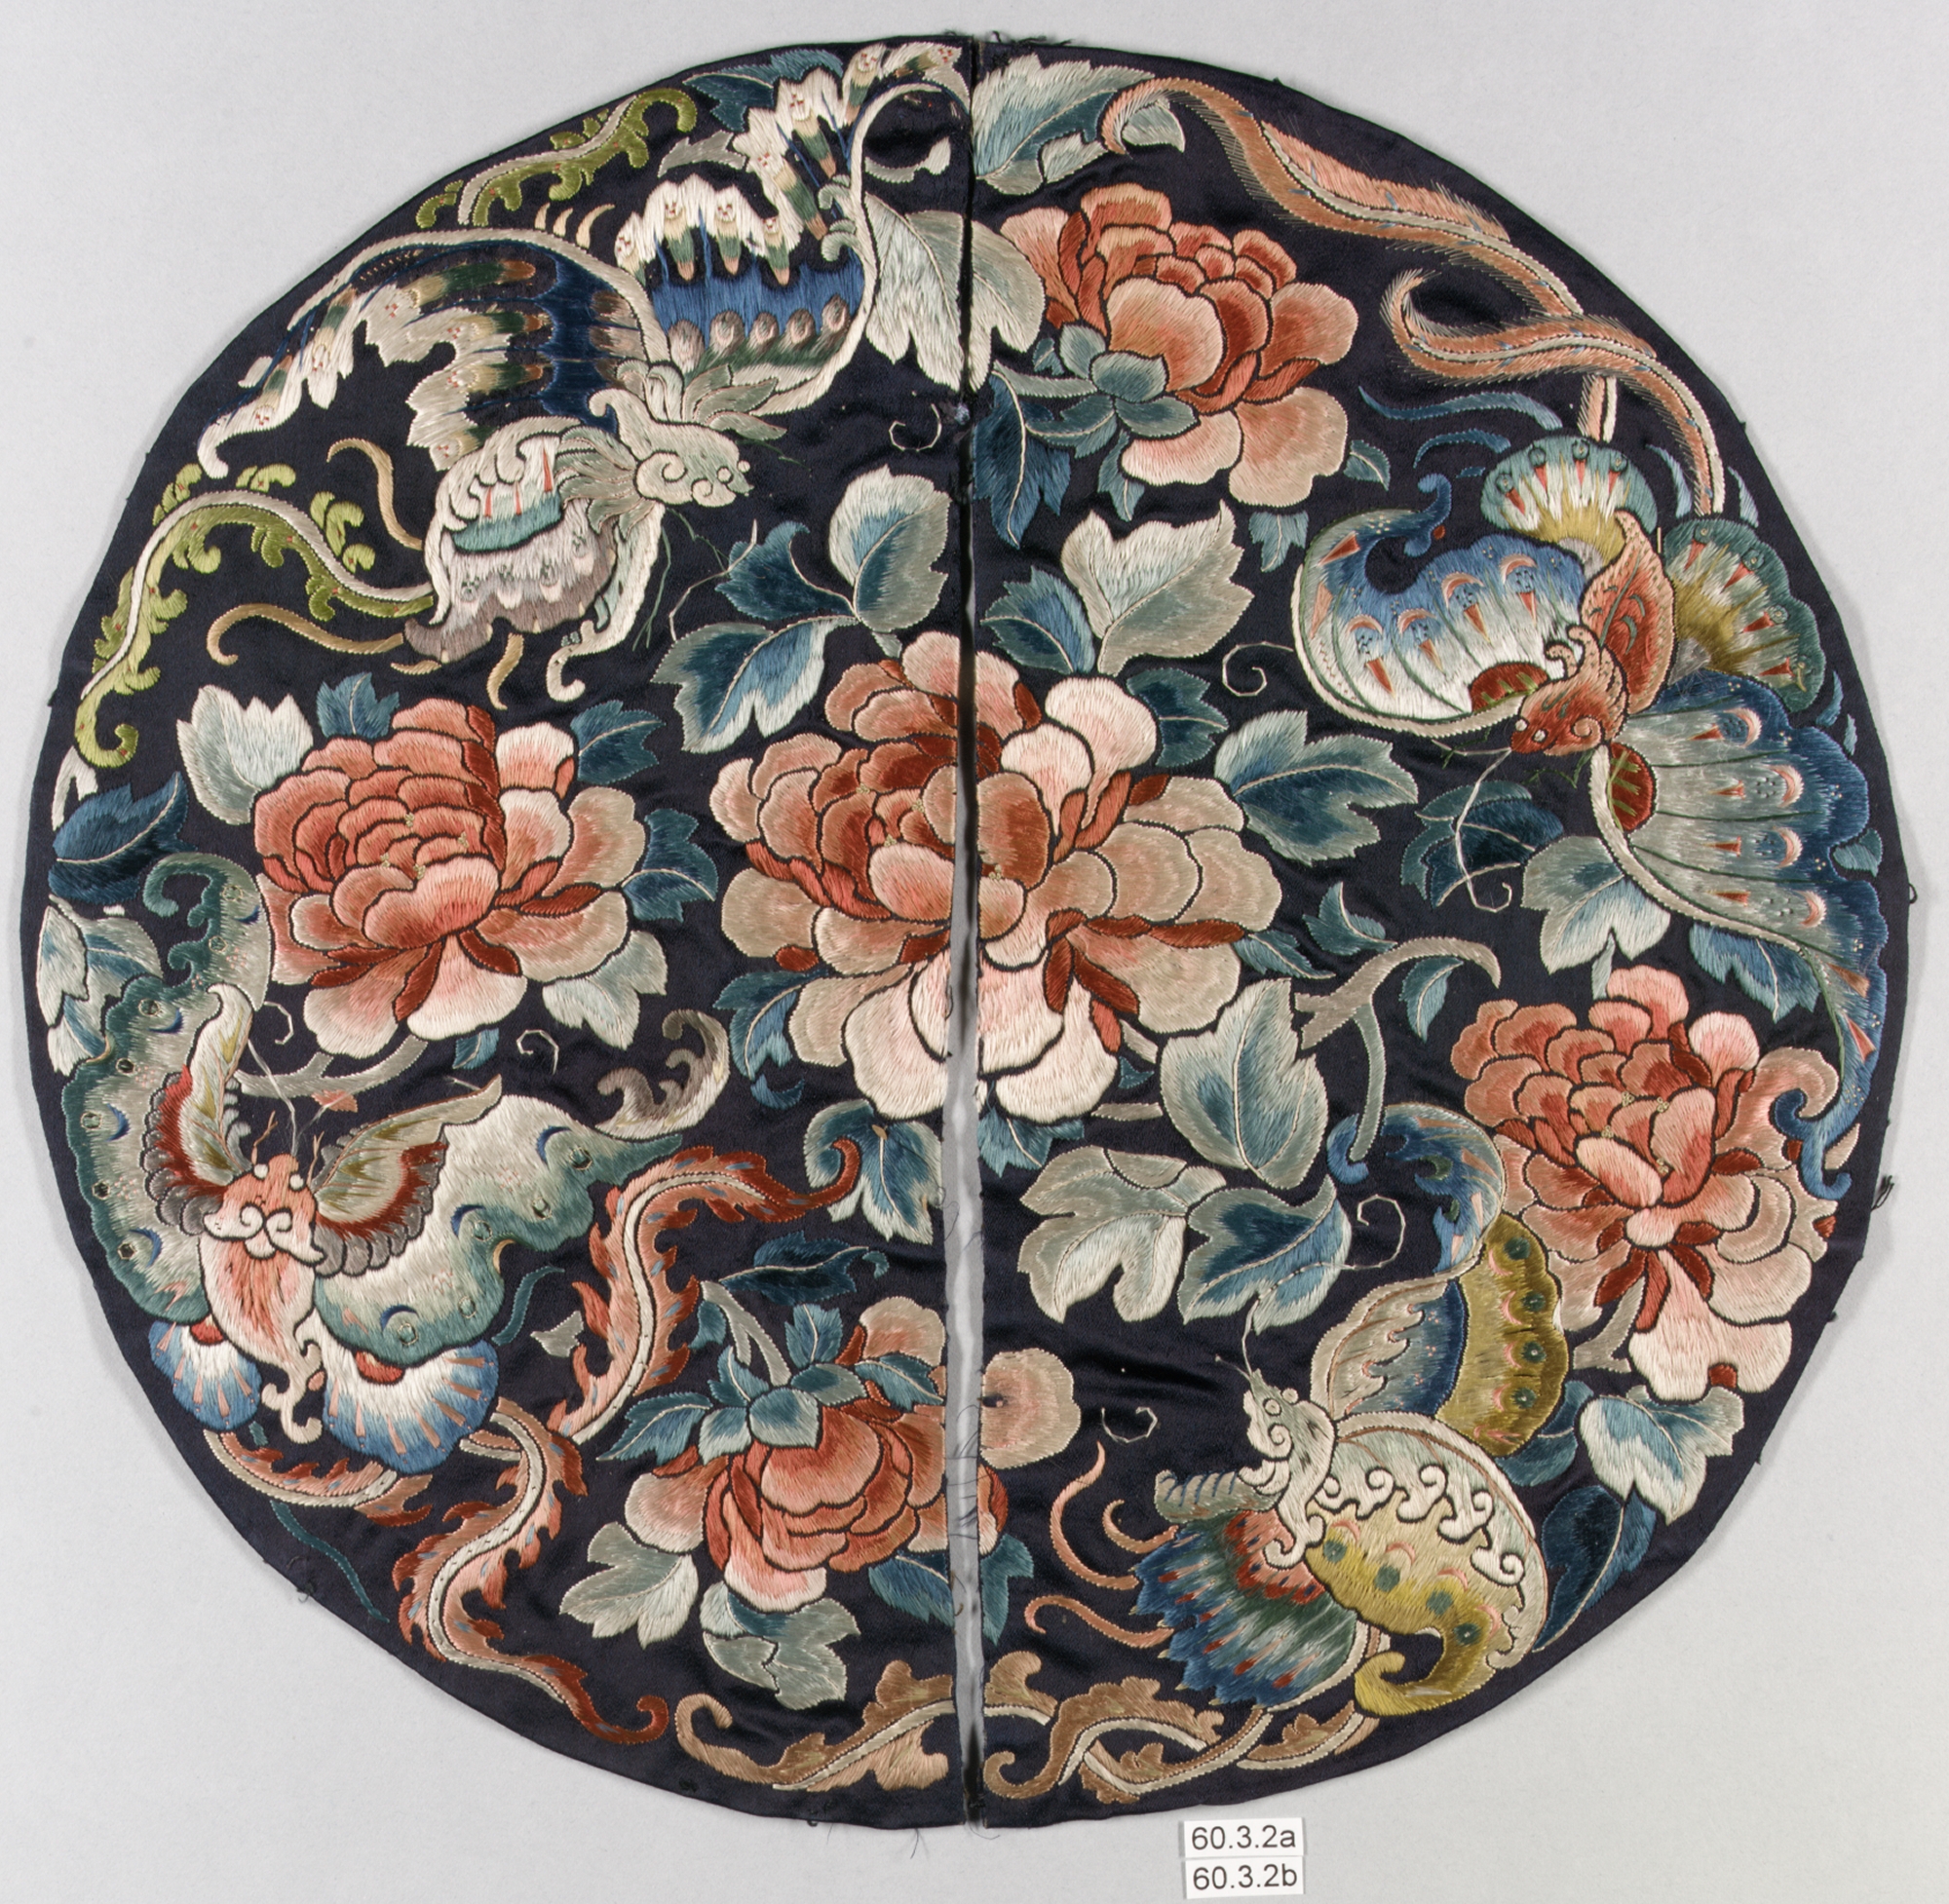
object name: medallion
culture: chinese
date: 1801-1900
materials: silk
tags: butterflies,flowers,leaves